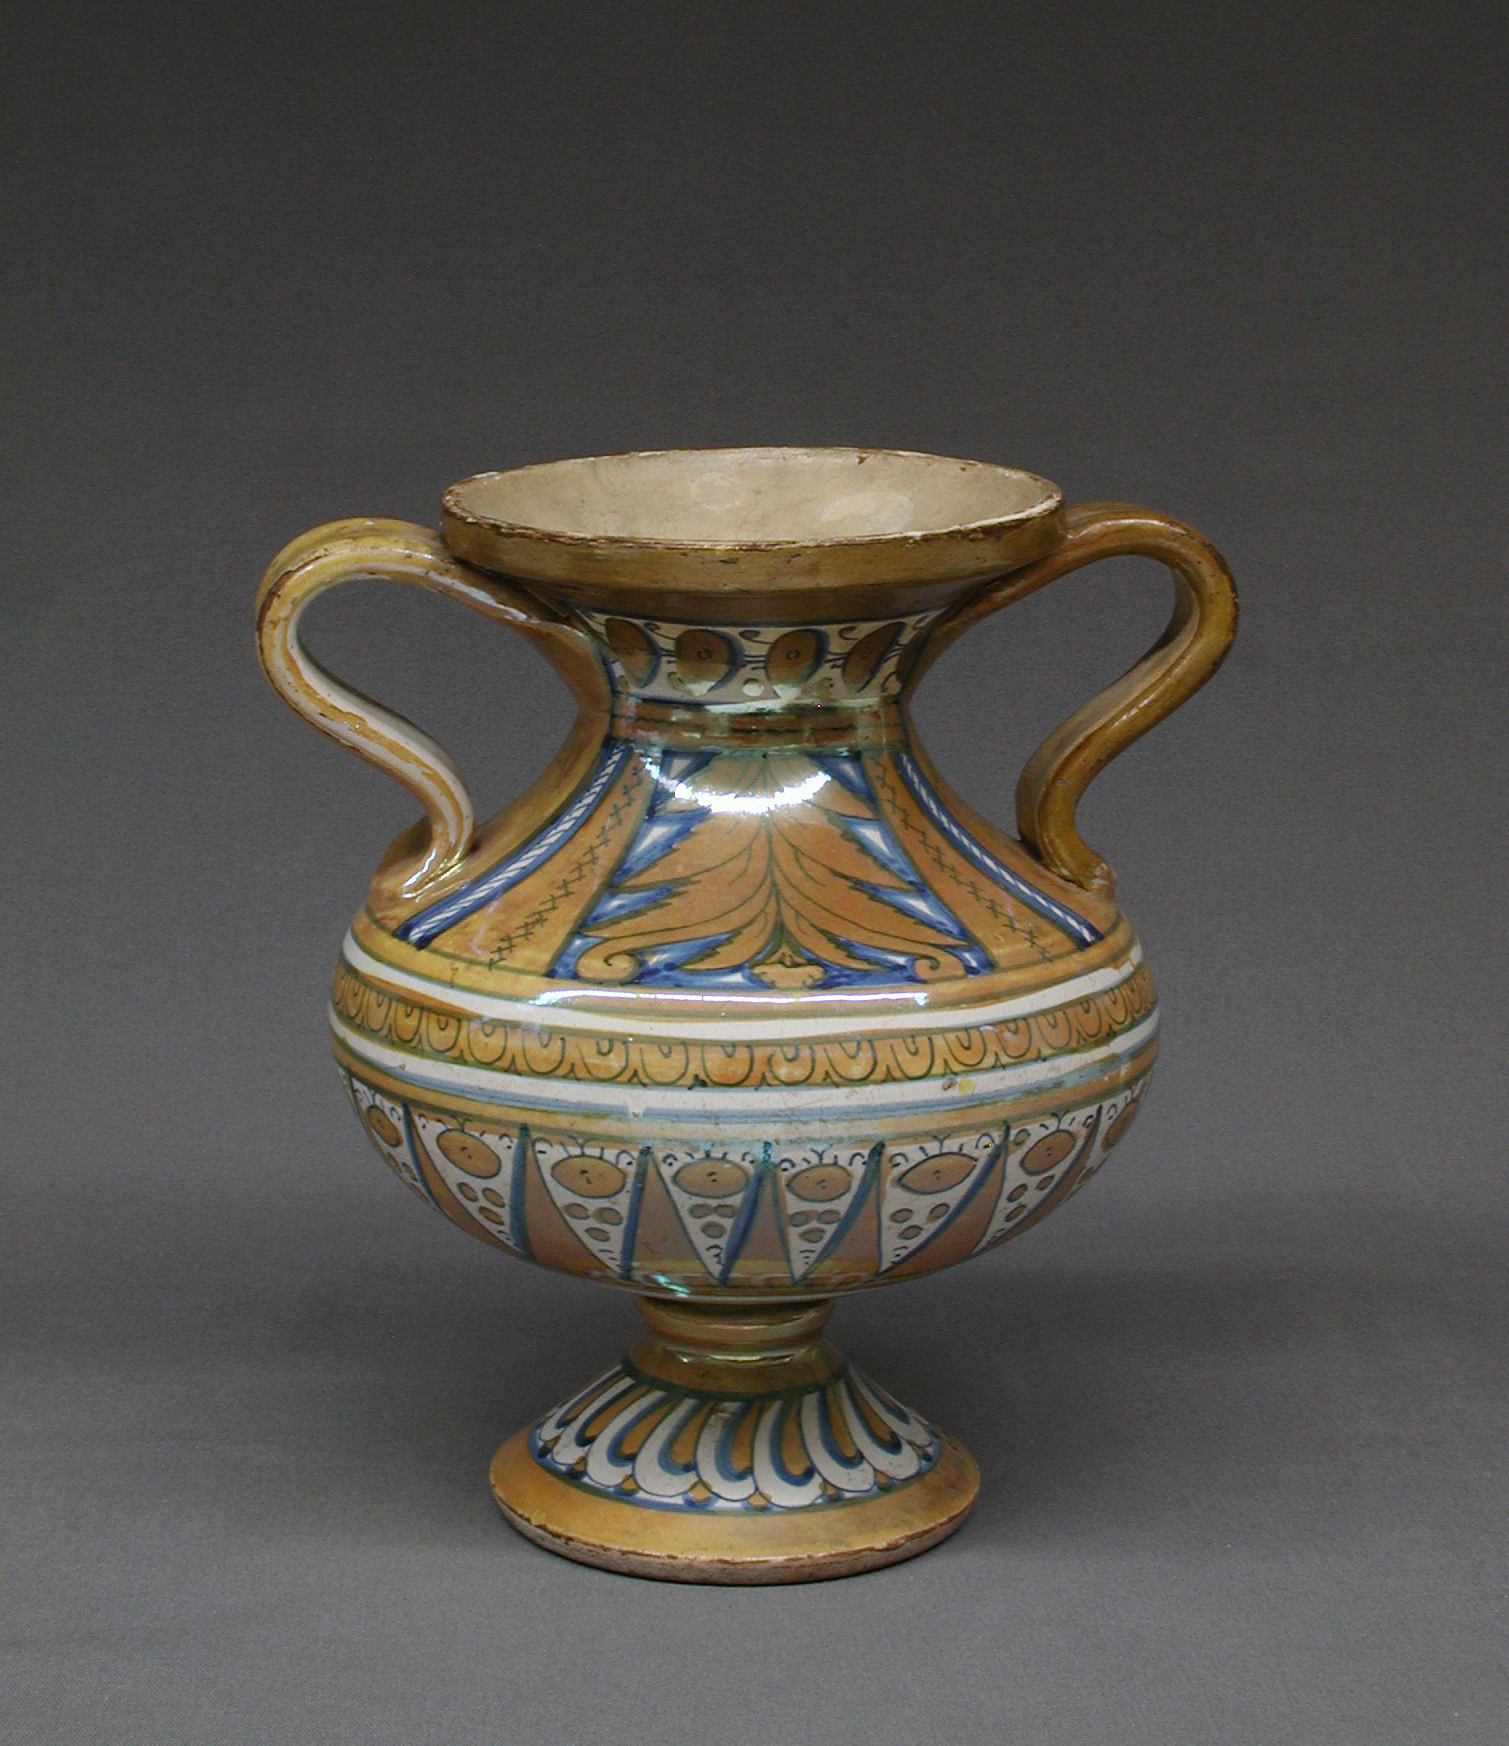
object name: vase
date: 1520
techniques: maiolica, glazing